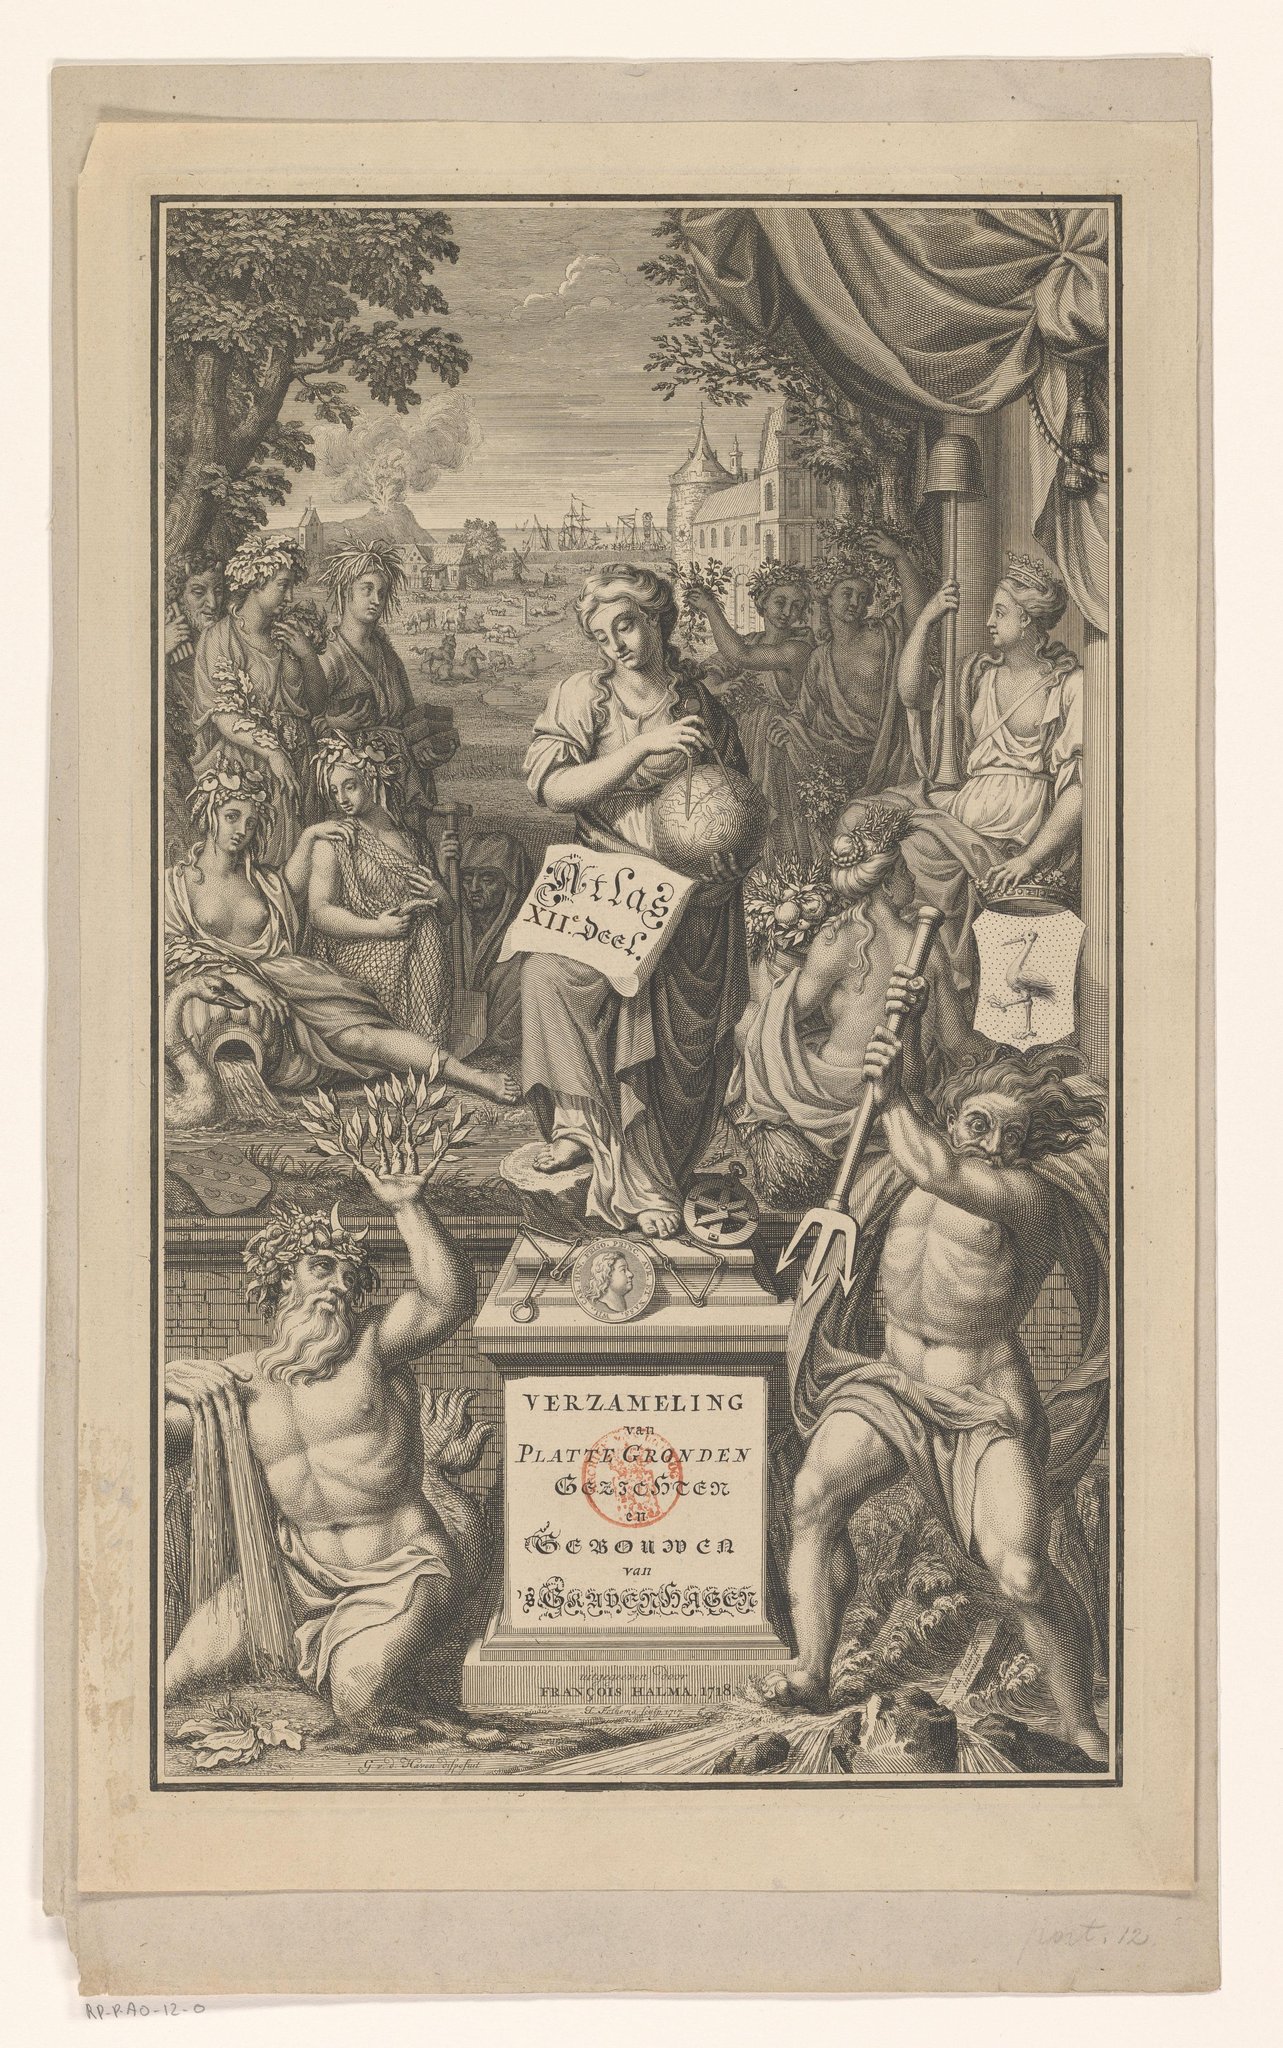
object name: titelprent, frontispice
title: Atlas XIIe. Deel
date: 1717-1718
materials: ink, paper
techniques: engraving, etching, pen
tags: commercial fishery, (story of) ceres (demeter), coat of arms (as symbol of the state, etc.) (+ city; municipal), peat-cutting, 'astronomia', 'cosmografia'; 'cosmografia' (ripa), personifications of countries, nations, states, districts, etc., river-gods, 'corografia', 'geografia', 'hidrografia' (ripa), agriculture, fruitfulness, productiveness, fertility, fecundity; 'fecondità' (ripa), (story of) flora, neptune as lord of the sea, the hague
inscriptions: collector's mark: Lugt 19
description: Deze prent is hier gebruikt als titelprent van een deel van een ongebonden atlas; een verzameling cartografische en topografische prenten en tekeningen. Oorspronkelijk was de prent echter bedoeld als titelpagina voor een gebonden atlas met kaarten van Friesland, waardoor een deel van de hier volgende beschrijving betrekking heeft op die context. Op het voetstuk in het midden staat de personificatie van de cartografie, met in haar hand een aardbol die ze met een passer meet. Op haar bovenbeen rust een blad met het handgeschreven deel van de atlas (oorspronkelijk een kaart van Friesland). Aan haar voeten een meetketting, een rond (land)meetkundig instrument en een portret van Willem IV van Oranje-Nassau. Daaronder de handgeschreven titel van dit deel van de atlas. Ze houdt een wakend oog op Wispelturigheid (Wispeltuer), linksonder. Oorspronkelijk staat hij voor de wispelturigheid waar het Friese land zich naar moest schikken: een bos kon opeens onder water staan, want zijn lichaam smelt door het zoute water van de zee. Linksboven zijn hoofd een wapenschild met het wapen van Friesland (met schuinbalken en pompeblêden). De dreiging van de zee is rechtsonder verbeeld door een onstuimige Neptunus (Zeevoogd). Links en rechts van Cartografie nog meer figuren die oorspronkelijk betrekking hadden op Friesland en haar vruchtbare natuur, visserij en landbouw. Links, met haar arm leunend op een kruik waar water uitstroomt, een stroomgodin (Stroomvoogdess) met rechts van haar de personificatie van de visserij (Visschevang). Boven hen van links naar rechts: een sater met fluit als personificatie van de natuur (Natuer), de personificatie van de bossen met eikenloven (Woudman) en personificatie van de turfwinning (vrouw Veenbrand). Rechtsonder haar vrouw Onland, die rouwt om de schade die de turfwinning aan het land veroorzaakt. Rechts van Cartografie zit Flora en/of Ceres (vrouw Veldgewas) met korenaren en cornucopia, ze staat voor de overvloed die voortvloeit uit het land. Boven haar, op de achtergrond, twee vrouwelijke personificaties die in verband staan met groene weides en/of grasvelden: Beemdeheil en Graazevol. Rechts, met in haar ene hand een bazuin met daarop een vrijheidshoed en in de andere hand een schild met het wapen van Den Haag, de personificatie van het gebied van dit deel van de atlas (oorspronkelijk de Friese Maagd met het provinciewapen met twee leeuwen). Op de achtergrond een landschap met kenmerkende Friese elementen, zoals het Sjaerdemaslot te Franeker en de vuurspuwende Rode Klif te Gaasterland (zou in de oudheid een vulkaan zijn geweest).